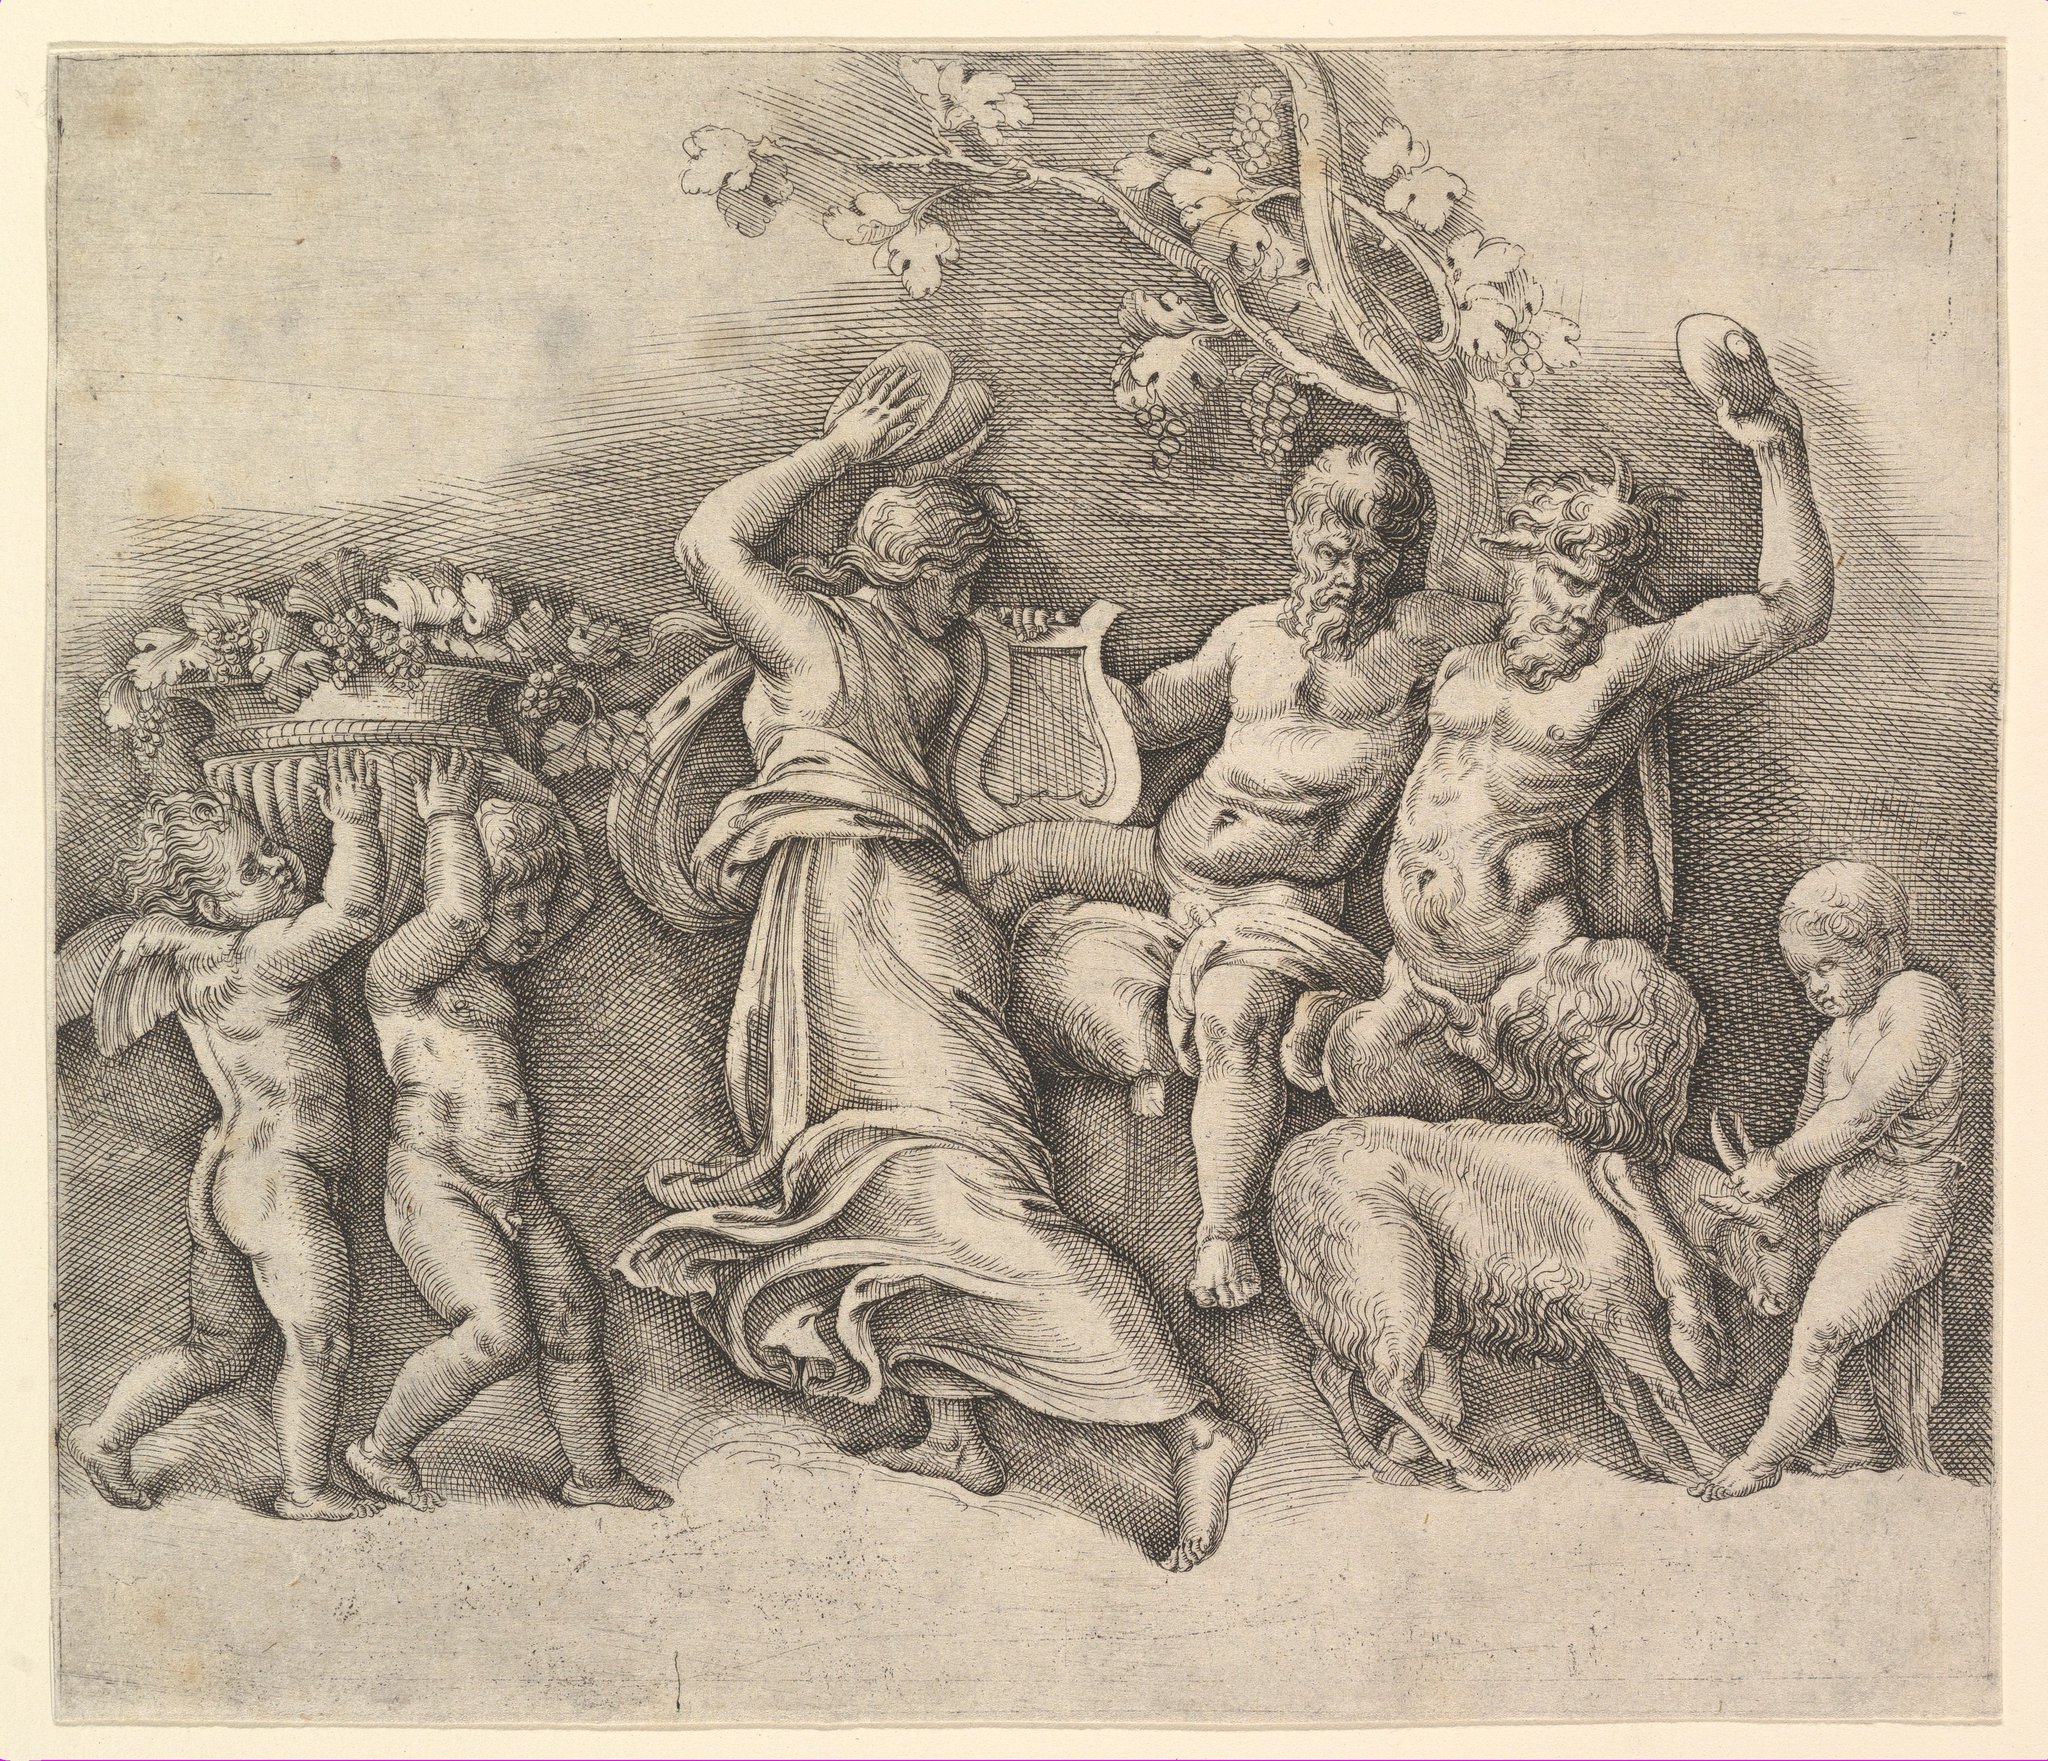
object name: print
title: A Bacchanal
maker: battista franco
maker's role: artist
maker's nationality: italian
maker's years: 1510-1561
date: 1530-1561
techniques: engraving, etching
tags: grapes,women,satyrs,sheep